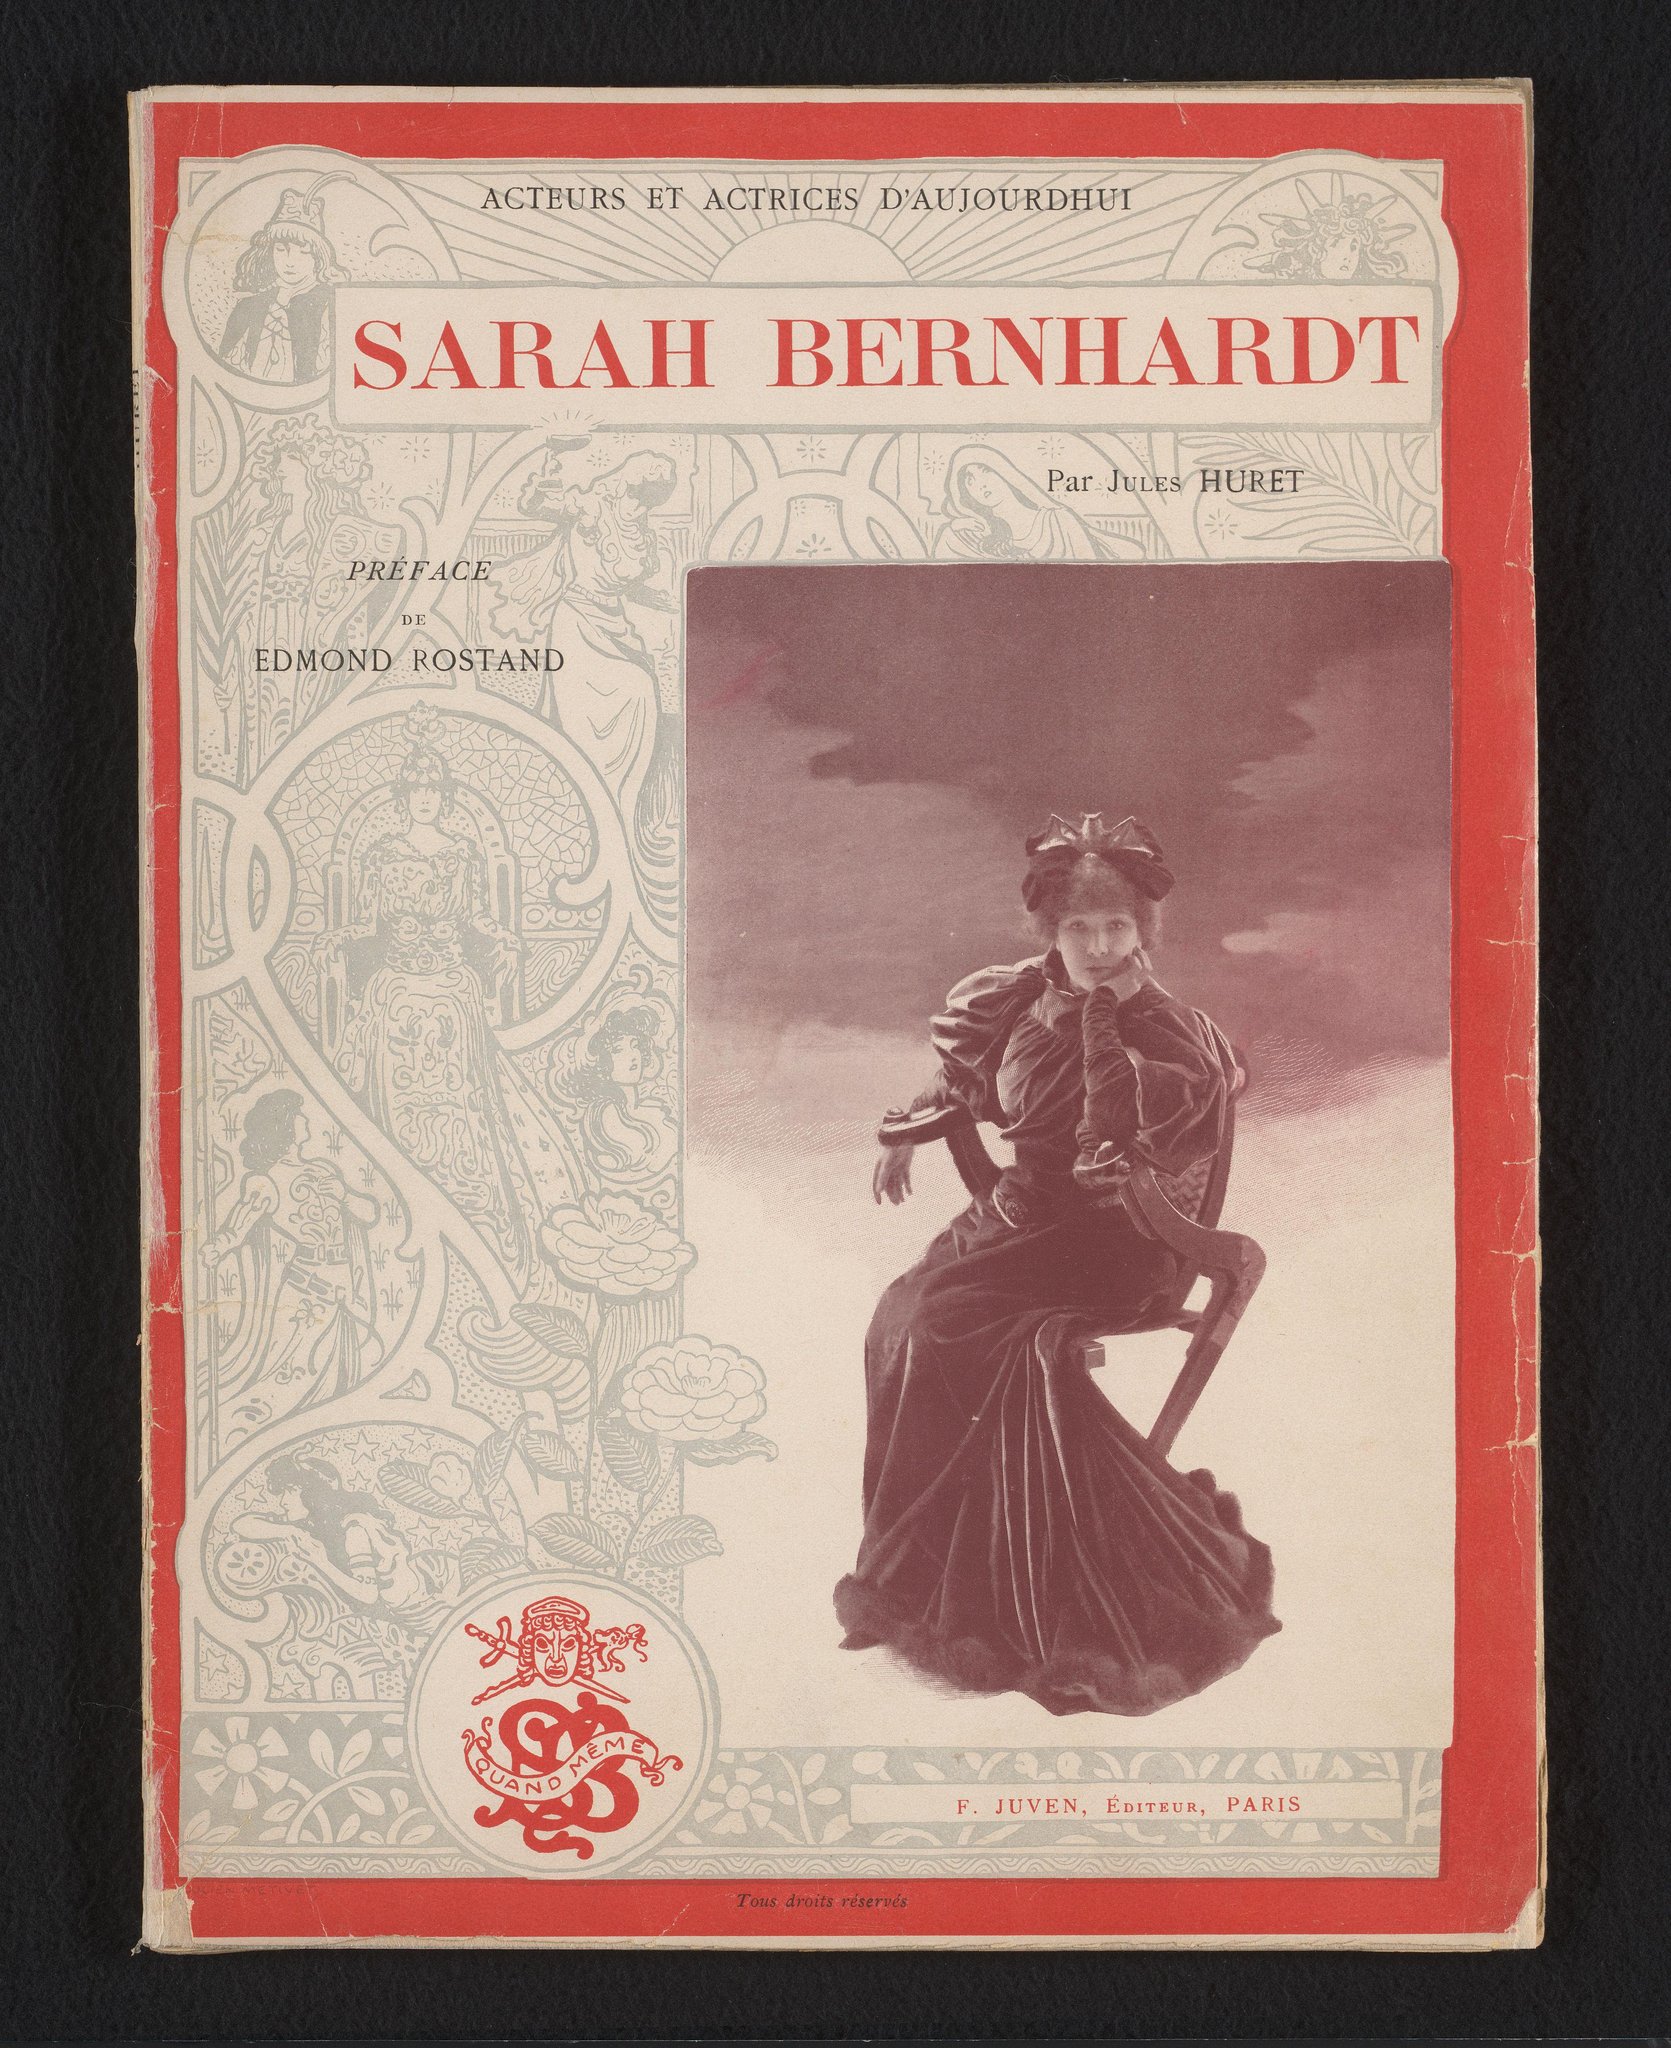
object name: magazine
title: Sarah Bernhardt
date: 1899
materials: paper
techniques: printing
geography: paris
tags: paris, sculptor, sarah bernhardt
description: Tijdschrift met 48 reproducties van foto's van Sarah Bernhardt door diverse fotografen.